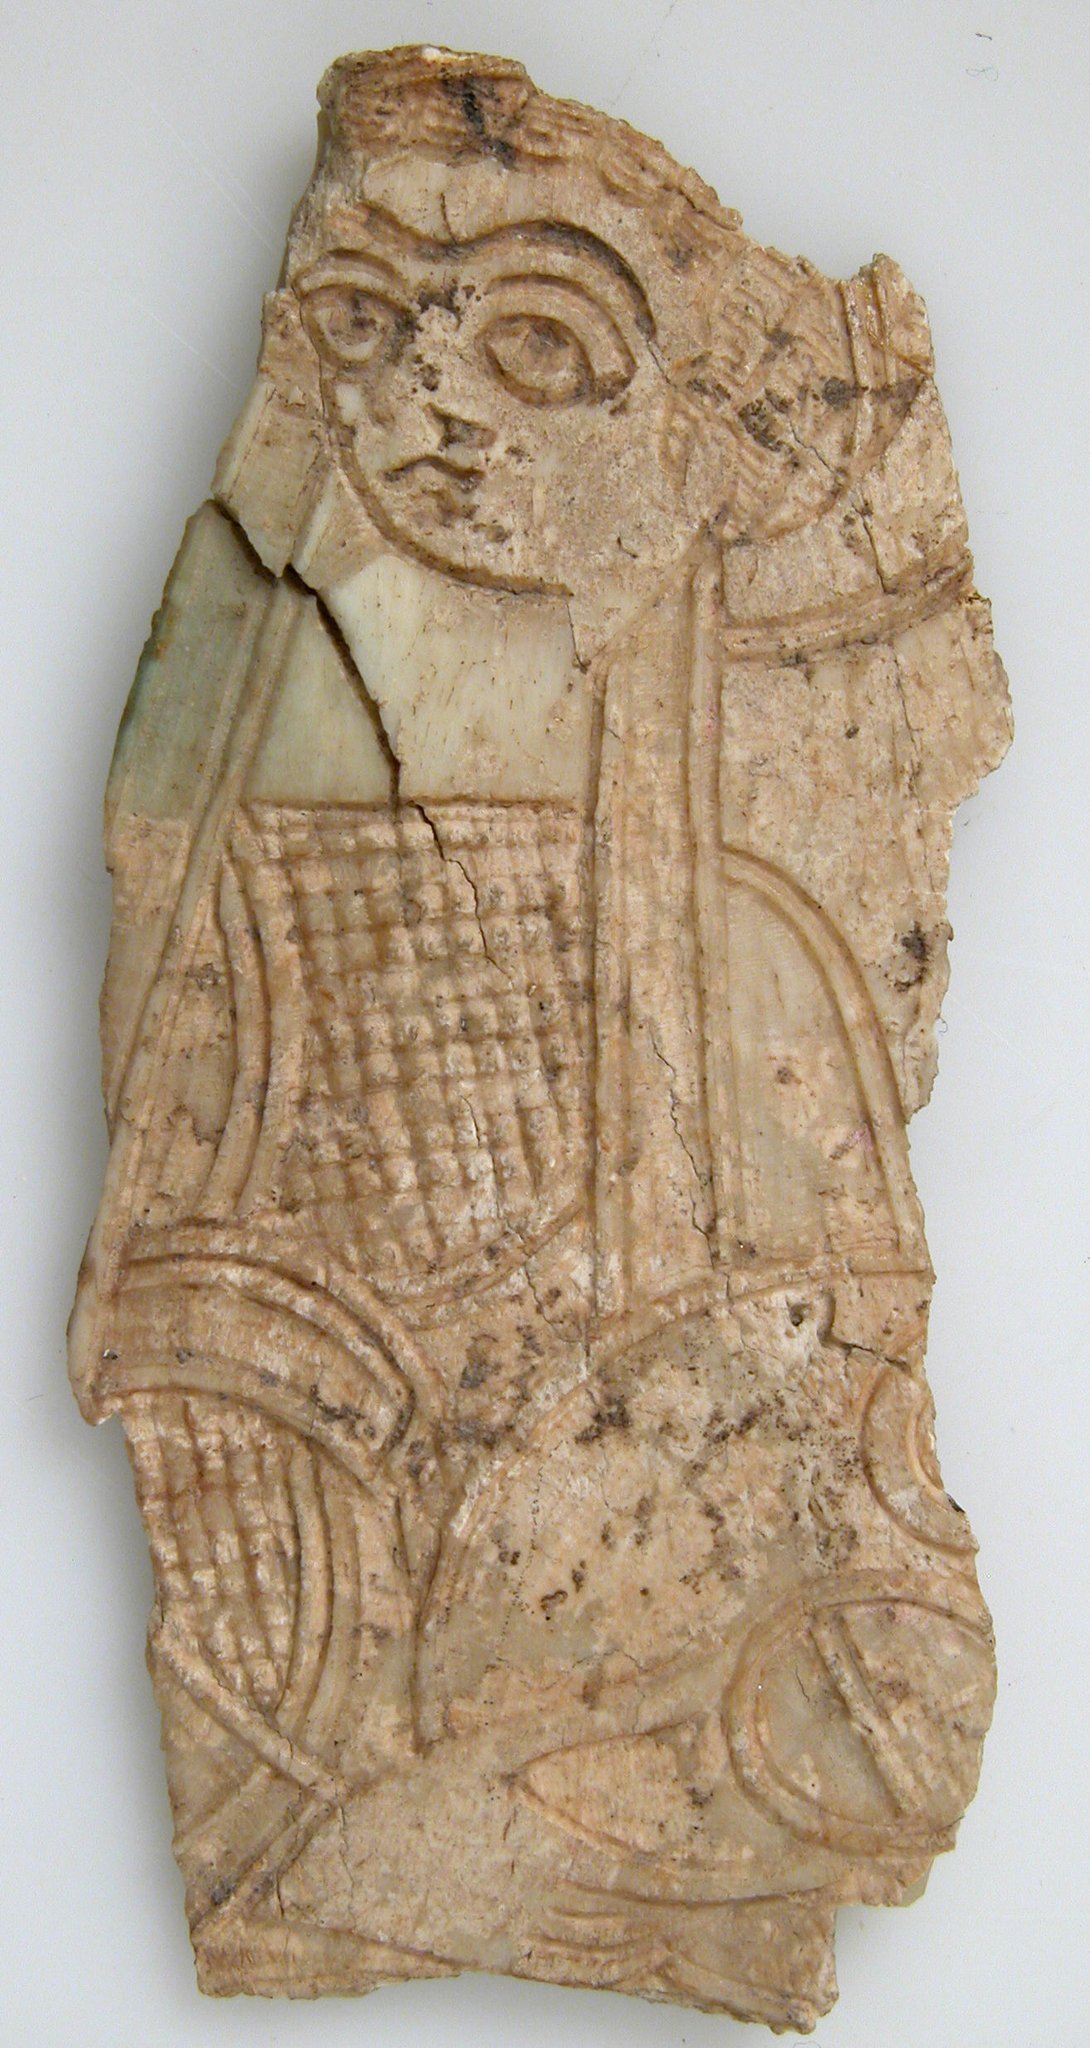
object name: plaque fragment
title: Fragment of a Plaque with a Standing Woman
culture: coptic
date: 301-400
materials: bone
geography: egypt